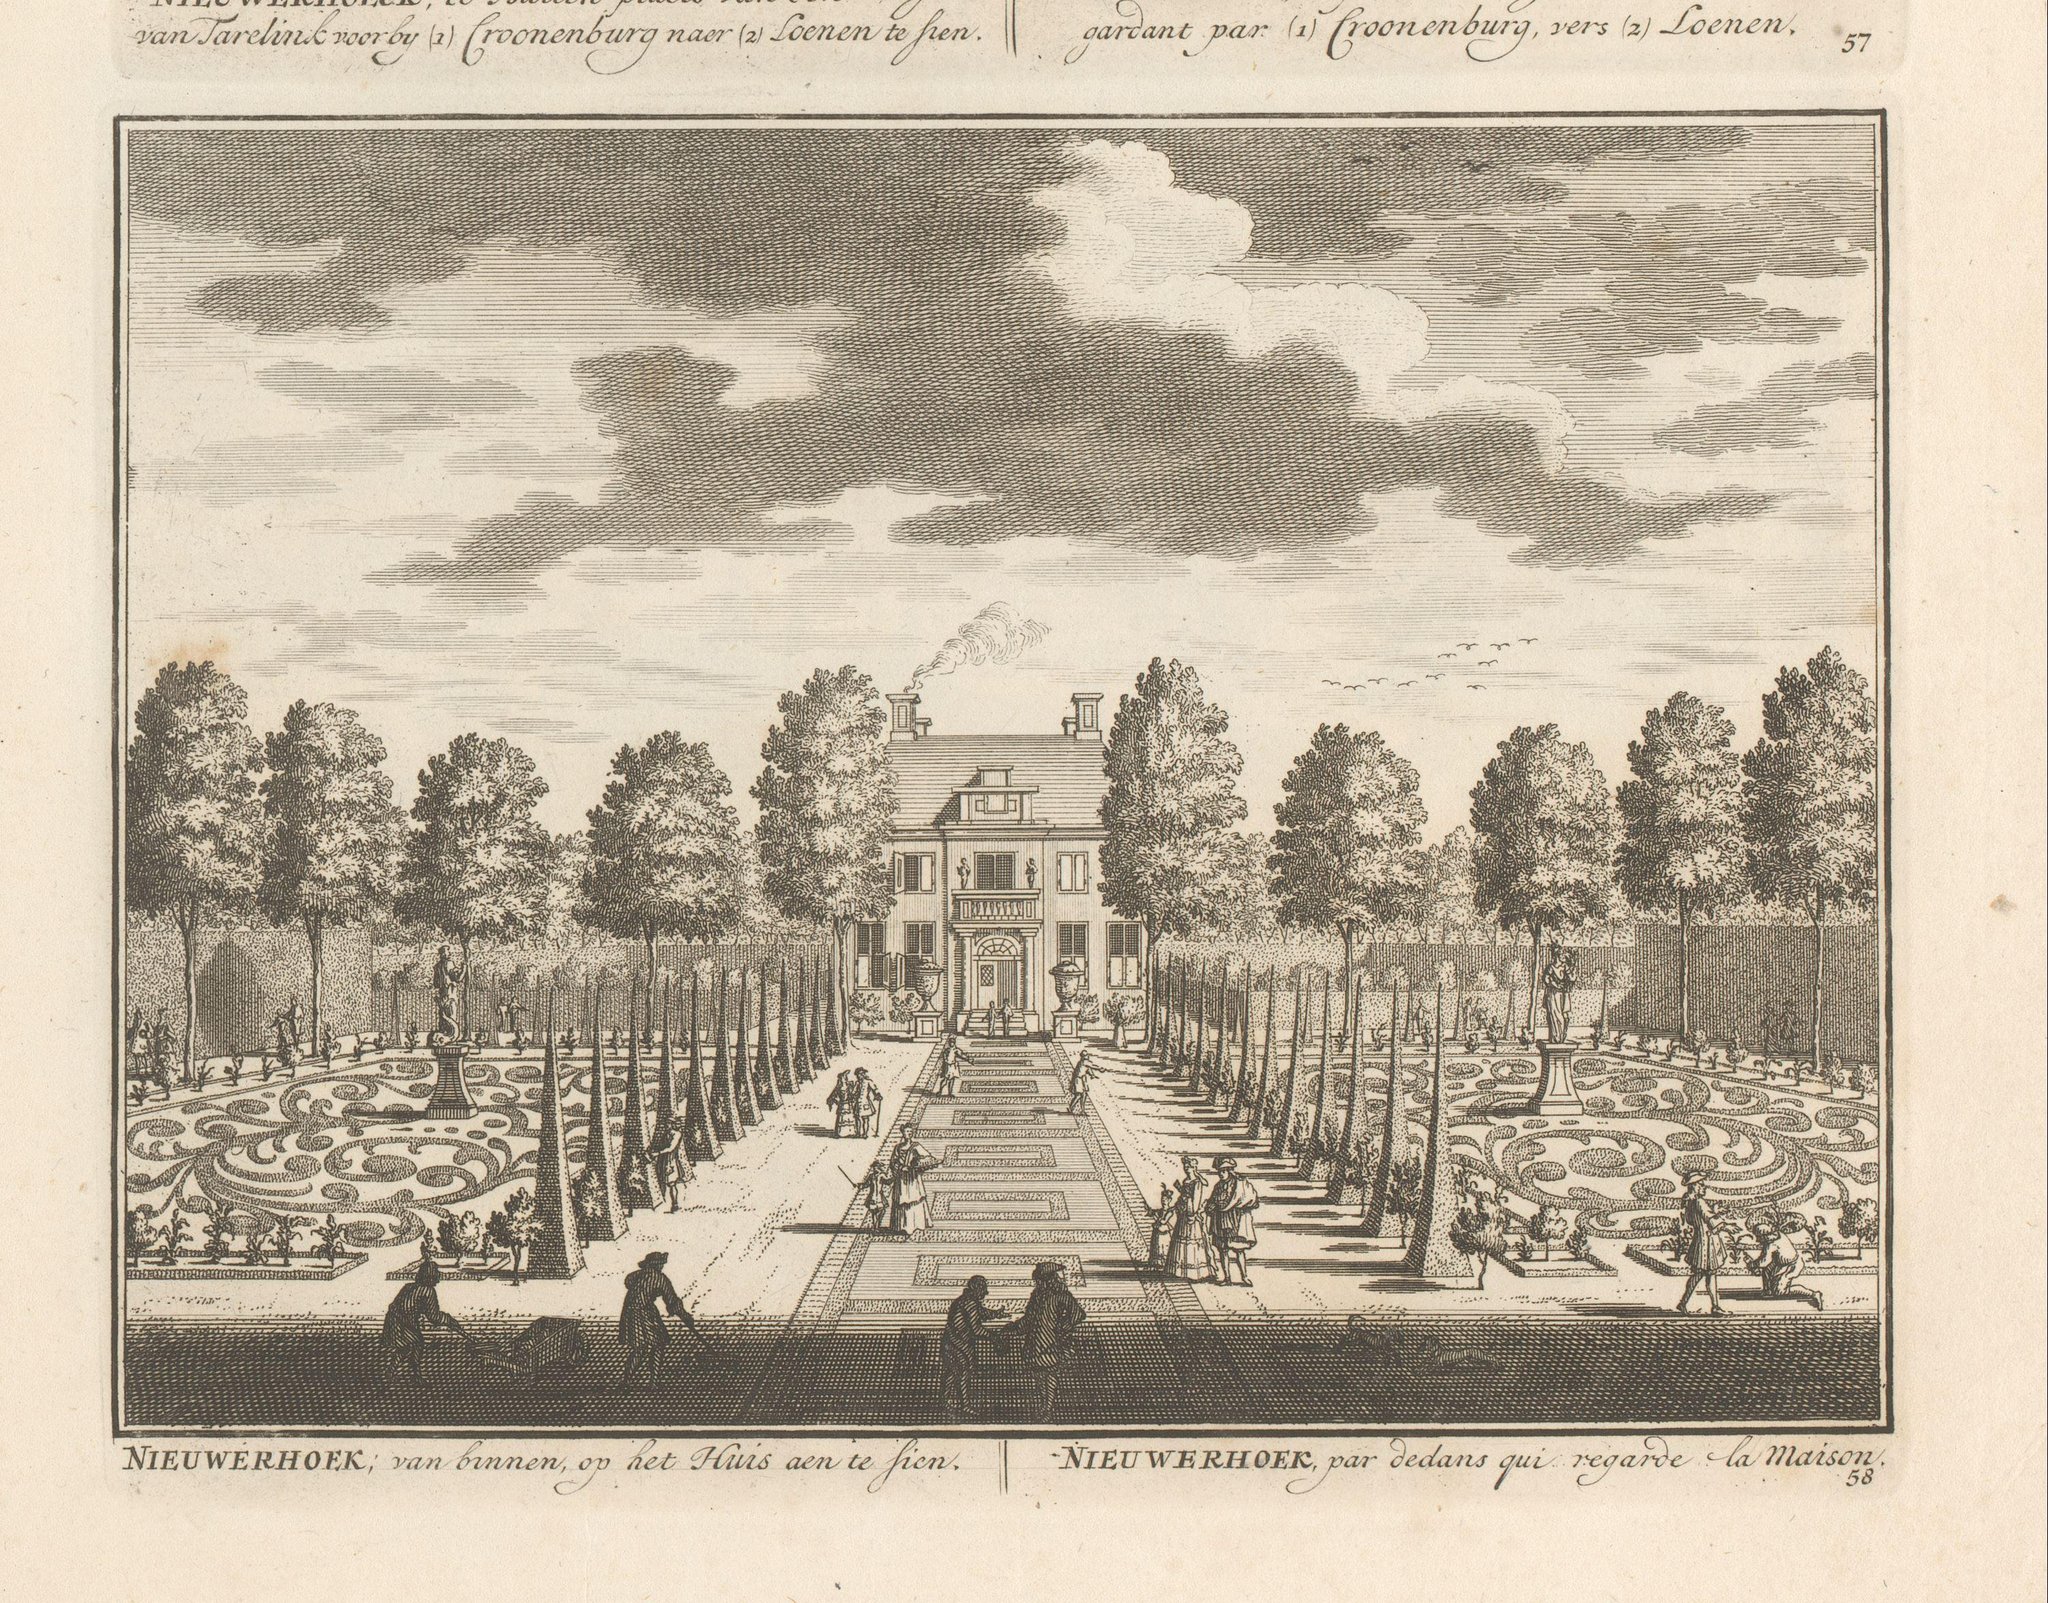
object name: print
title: Gezicht op de tuin van de buitenplaats Nieuwerhoek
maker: daniël stopendaal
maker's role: print maker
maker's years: 1672-1726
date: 1790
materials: paper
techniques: engraving, etching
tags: french or architectonic garden; formal garden, river (+ landscape with figures, staffage), country-house, vecht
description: Prent gebruikt in: Leth, Andries de. De zegepraalende Vecht, vertoonende verscheidene gesichten van lustplaatsen, heeren huysen en dorpen, beginnende van Uitrecht en met Muyden besluytende (...). Amsterdam: Weduwe Nicolaus Visscher, 1719. Prent ook gebruikt in: Brouërius van Nidek, Matthaeus. De Vechtstroom, van Utrecht tot Muiden (...). Amsterdam: H. Gartman, W. Vermandel en J.W. Smit, 1790.